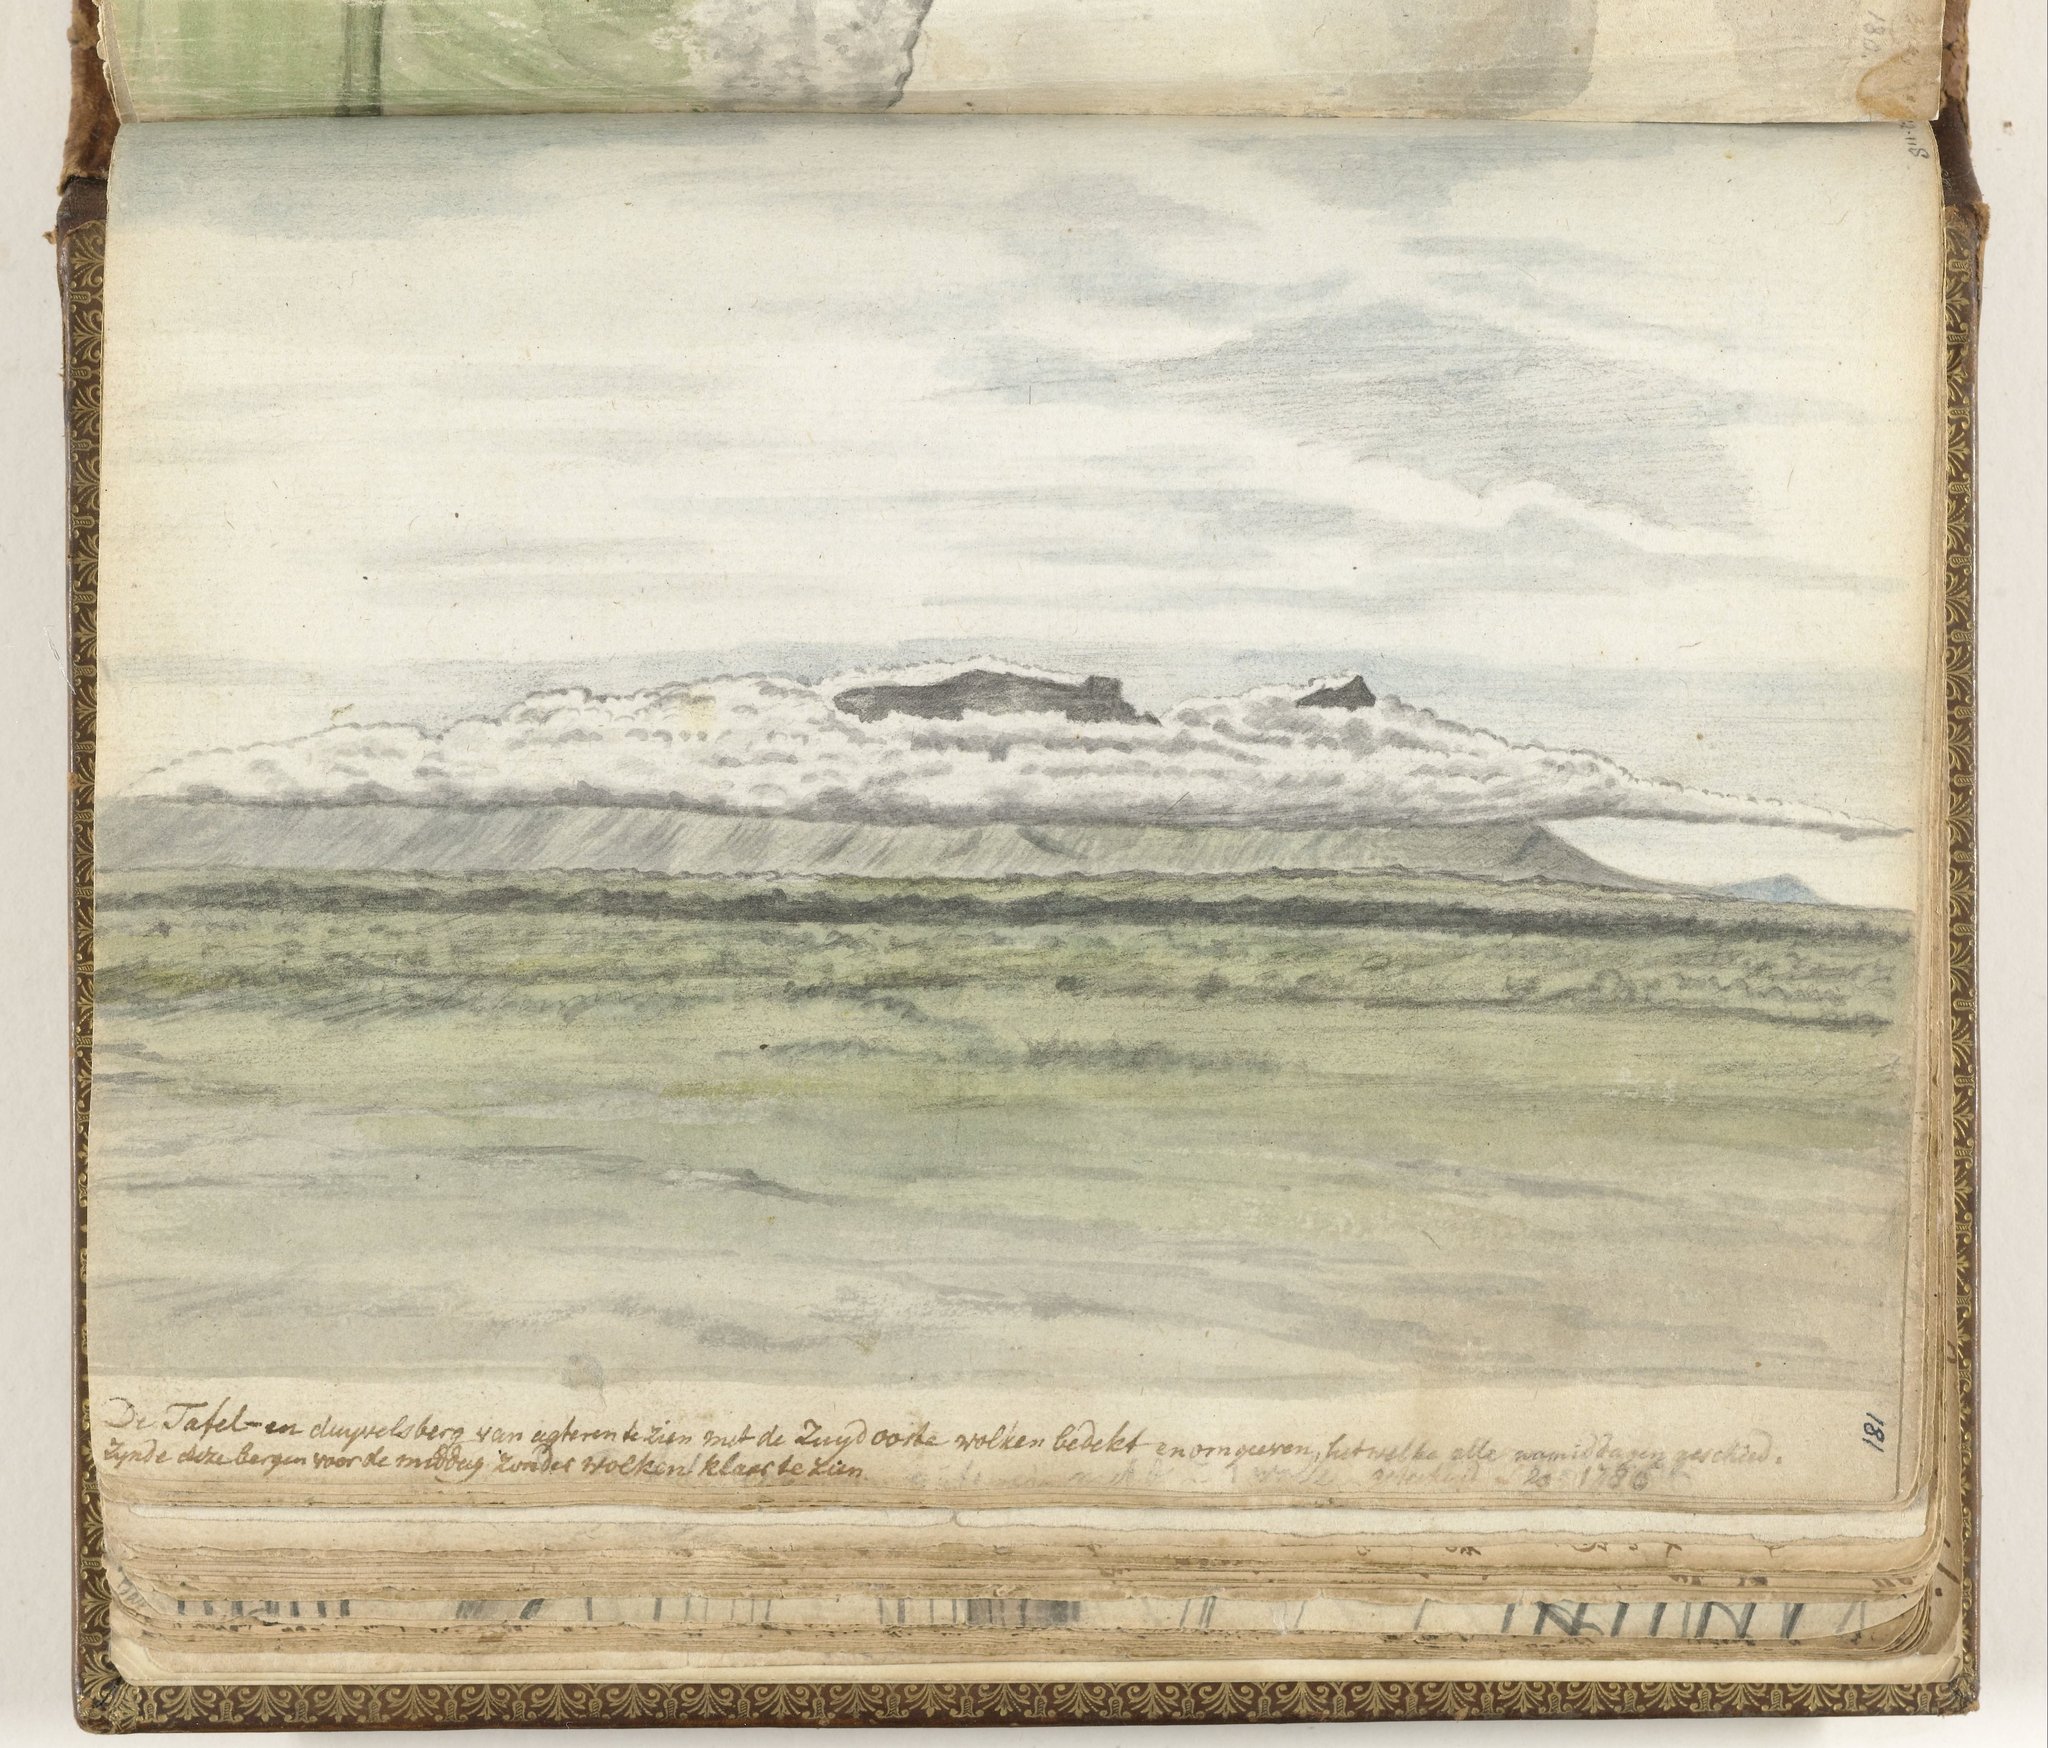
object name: drawing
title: Tafel- en Duijvelsberg van de landzijde gezien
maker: jan brandes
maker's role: draughtsman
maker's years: 1743-1808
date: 1786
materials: paper, pencil, watercolor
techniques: brush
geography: south africa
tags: mountains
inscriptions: date: ‘geteekend 20 ... 1786’, inscription: ‘De Tafel- en duyvelsberg van agteren te zien met de Zuydooste wolken bedekt en omgeeven, hetwelke alle namiddagen geschied. Zynde deze bergen voor de middag zonder wolken klaar te zien.’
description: Kleurtekening van een groene vlakte met in de verte de Tafel- en de Duijvelsberg met wolken omgeven. Met opschrift. Onderdeel uit het schetsboek van Jan Brandes, dl. 2 (1808), p. 181.